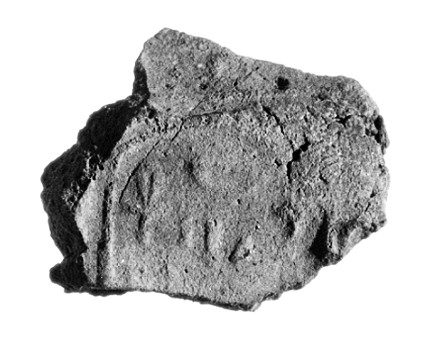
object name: sealing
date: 2030-1640 BCE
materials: clay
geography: egypt